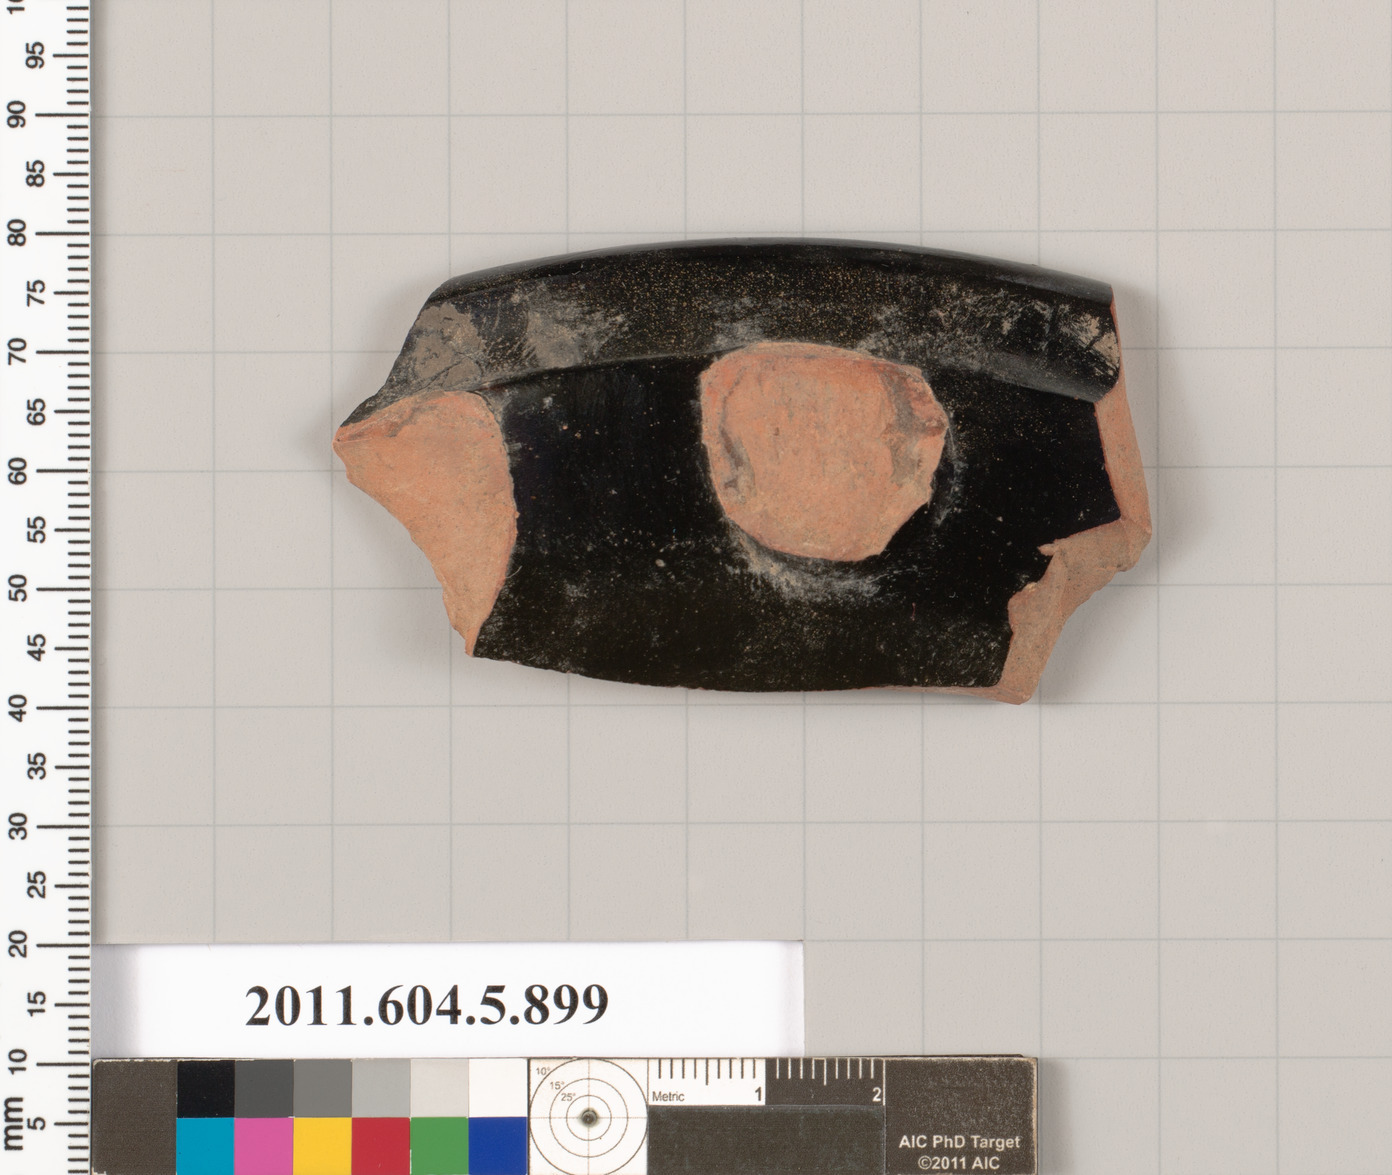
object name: kylix fragment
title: Terracotta rim fragment of a kylix (drinking cup)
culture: greek, attic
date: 600-401 BCE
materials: terracotta